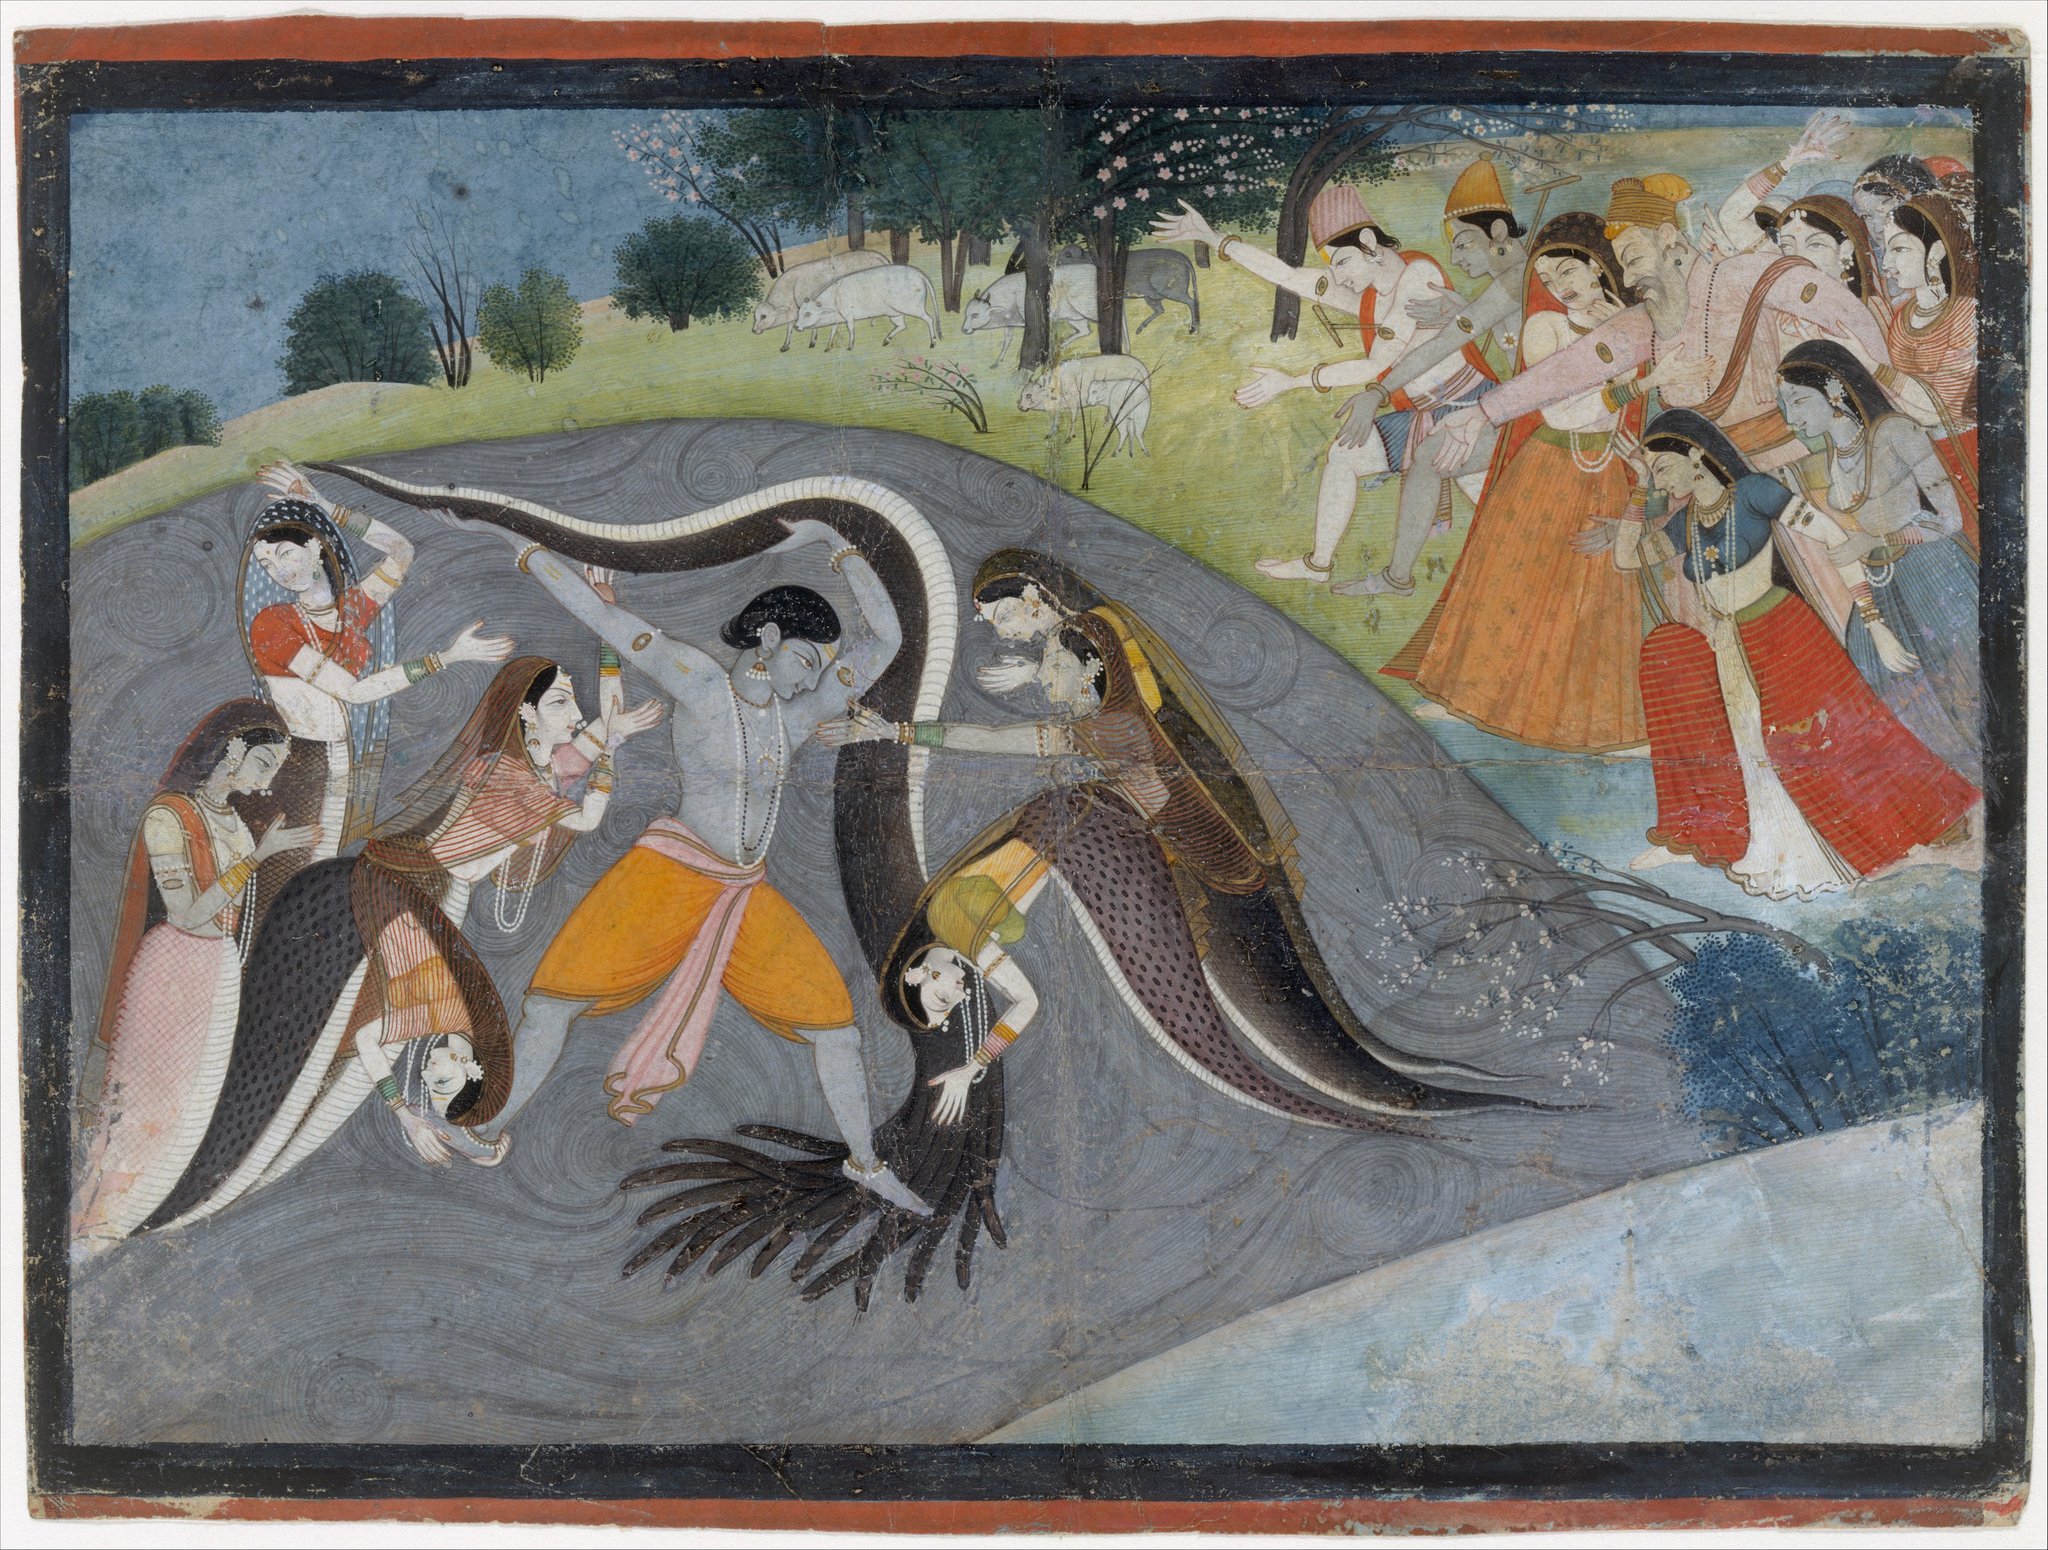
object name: folio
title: Krishna Subduing Kaliya, the Snake Demon: Folio from a Bhagavata Purana Series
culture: indian, northern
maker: first generation after manaku and nainsukh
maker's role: artist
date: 1785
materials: ink, paper, watercolor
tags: men,women,snakes,demons,krishna